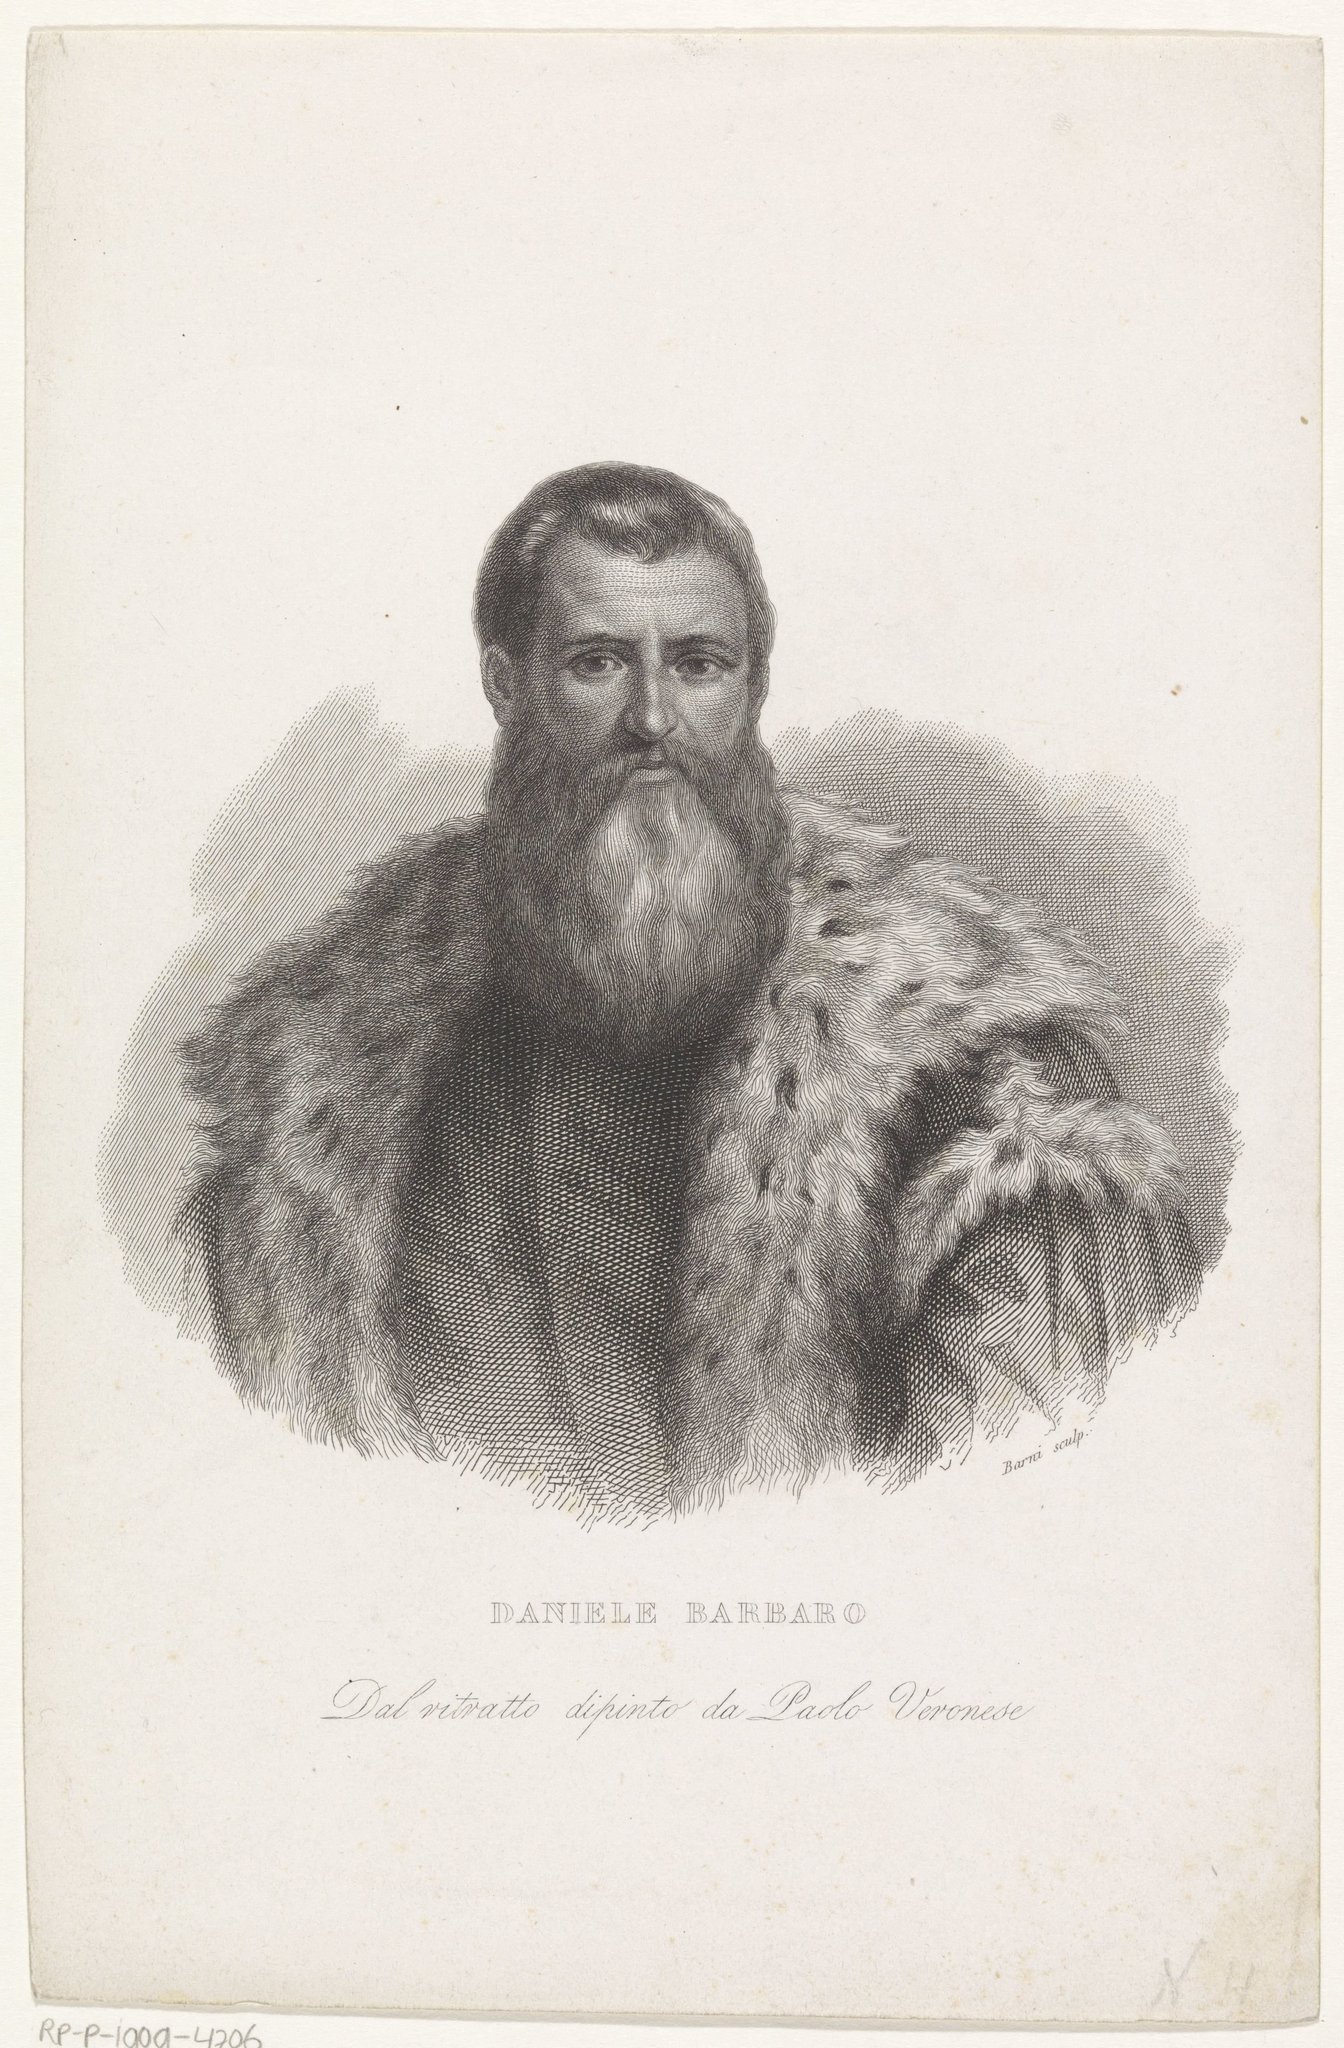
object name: print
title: Portret van Daniele Barbaro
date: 1845-1855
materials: paper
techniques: engraving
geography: florence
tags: historical persons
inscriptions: collector's mark: Lugt 2228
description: Naar portret door Paolo Veronese in het Palazzo Pitti in Florence.